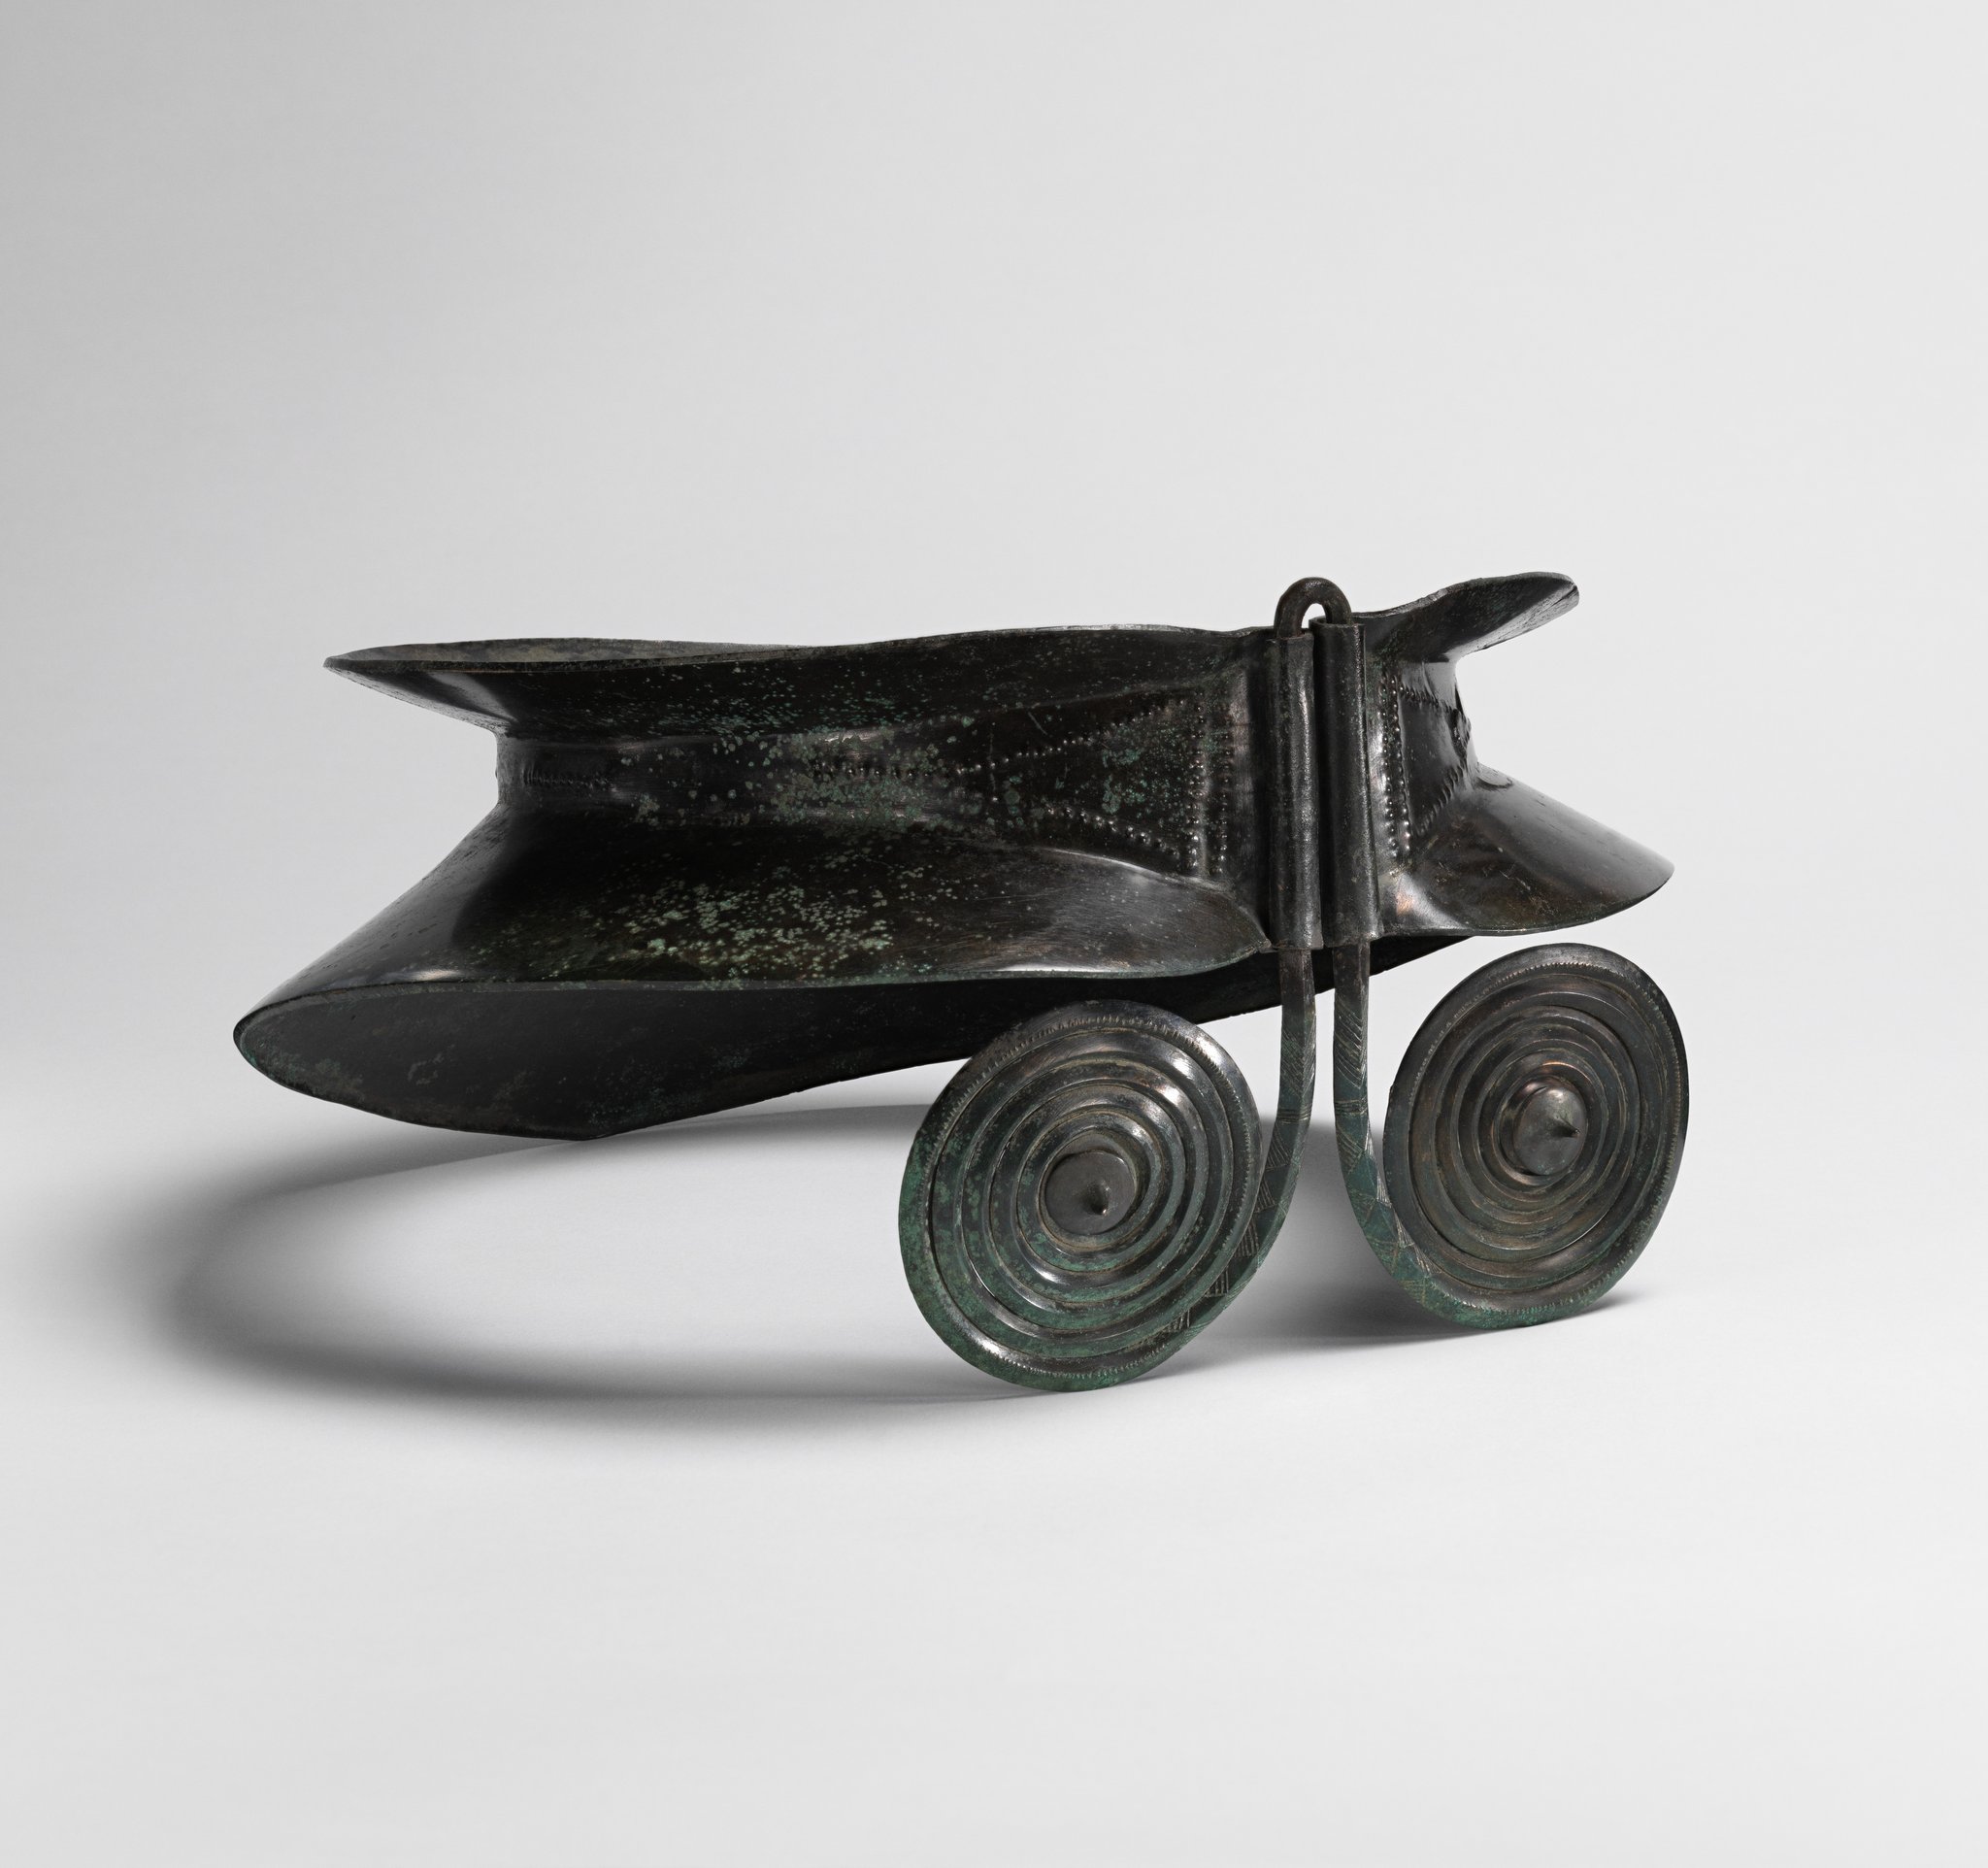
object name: diadem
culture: eastern european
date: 1200-800 BCE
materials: copper alloy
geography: east-central europe